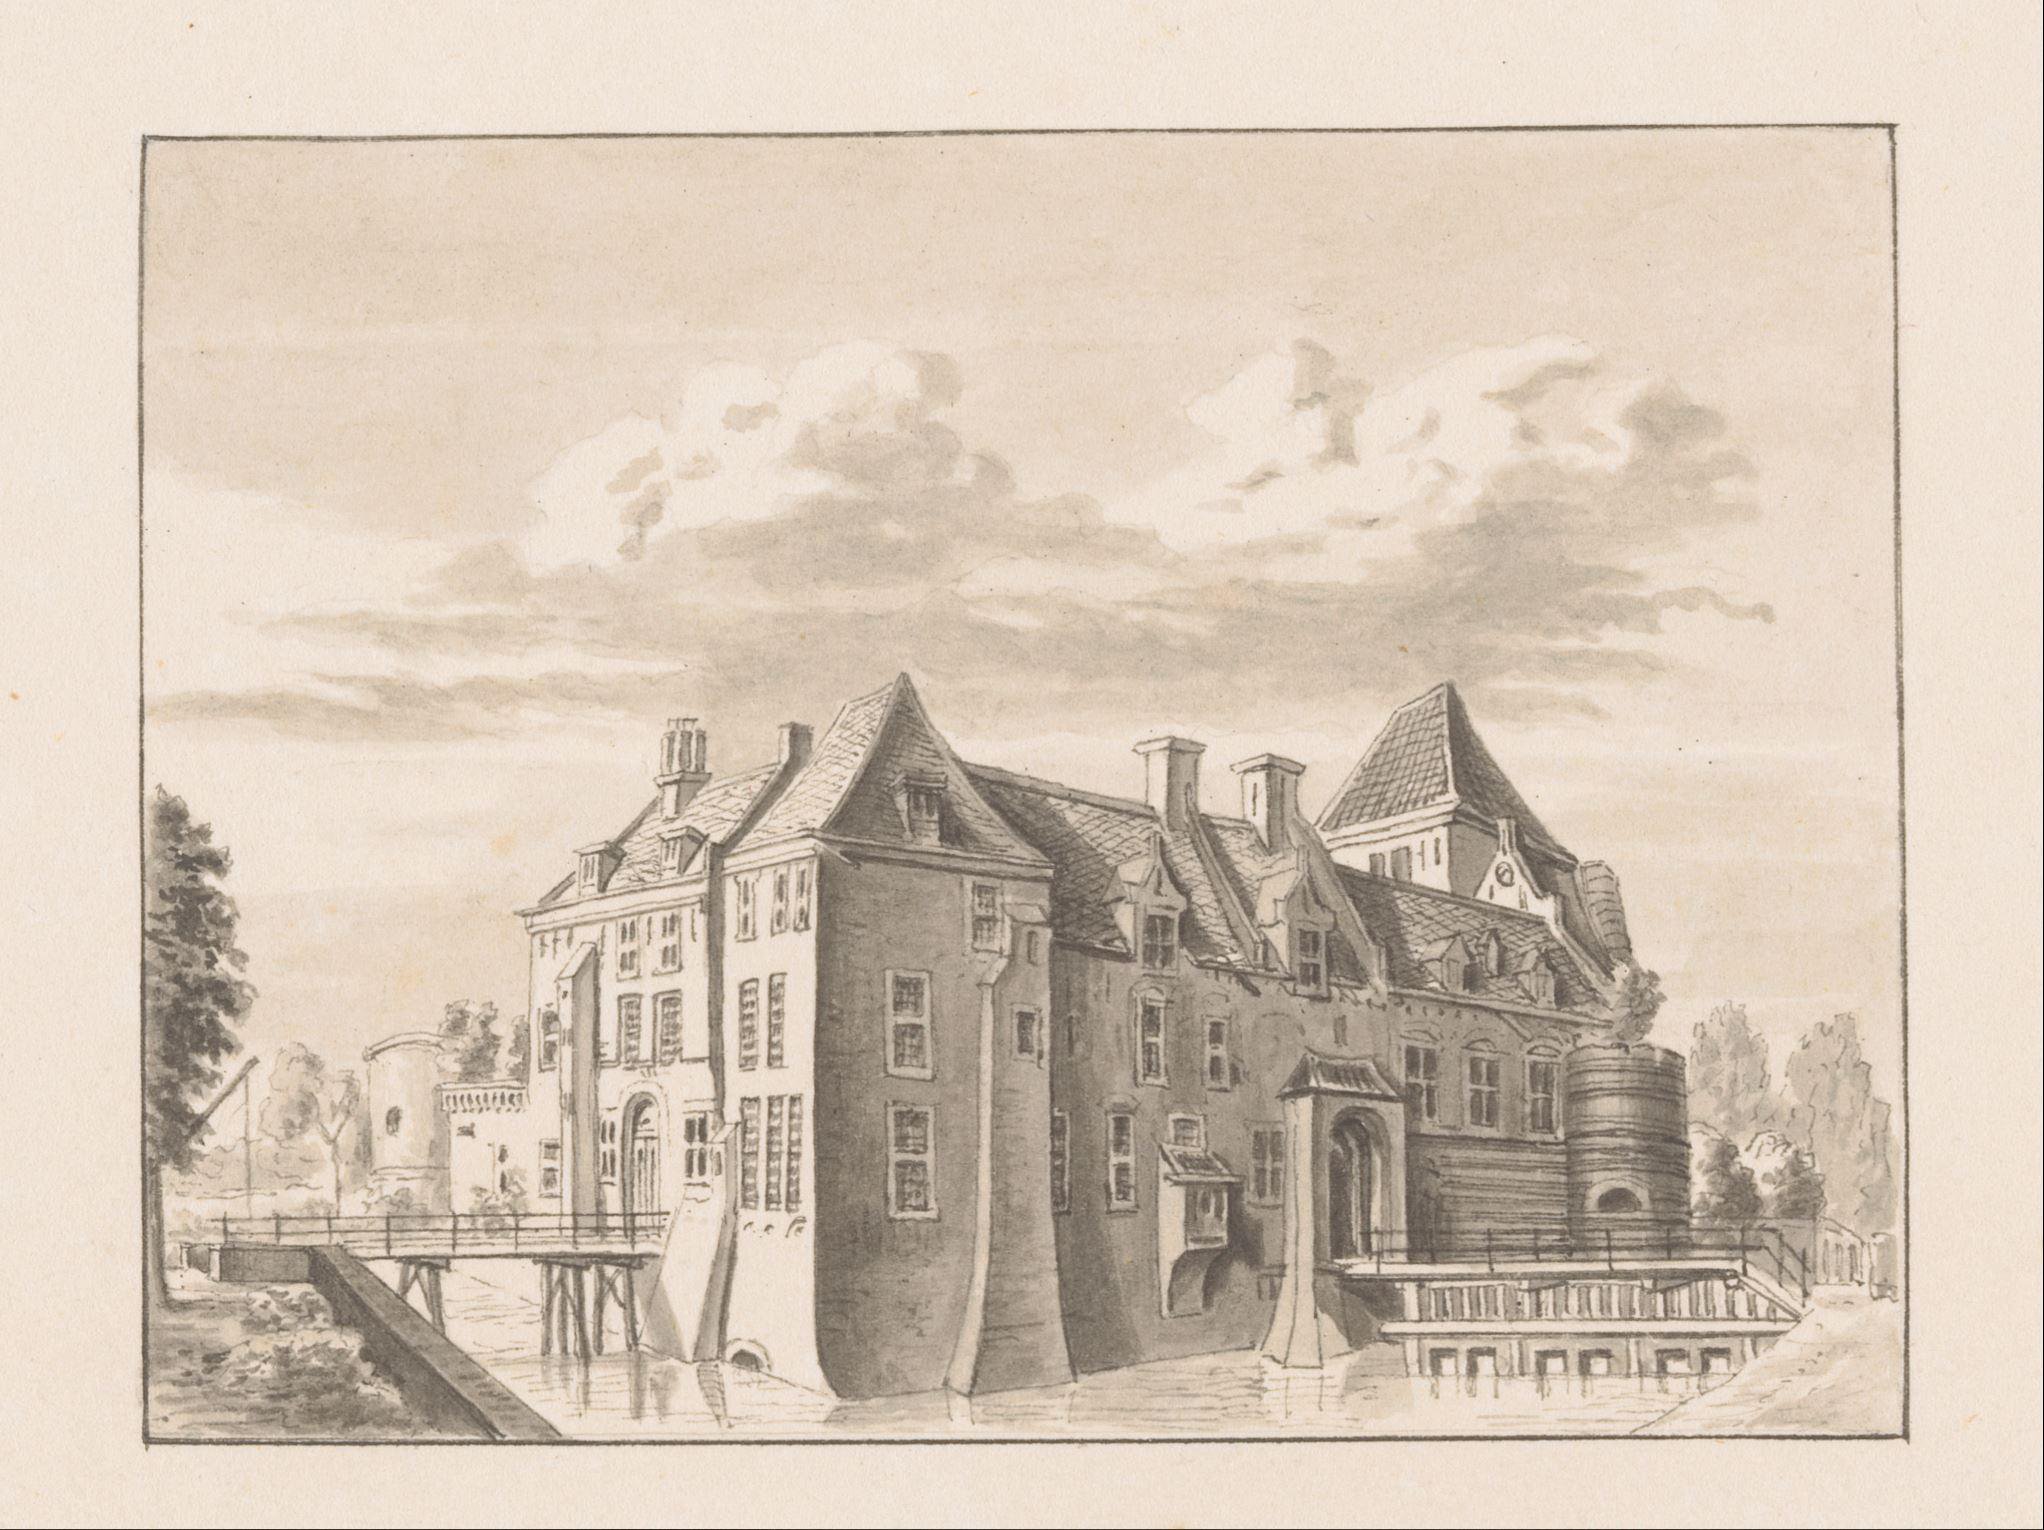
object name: kopie naar prent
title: Gezicht op kasteel IJsselstein in IJsselstein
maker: Anonymous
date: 1750-1850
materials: ink, paper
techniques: brush, drawing, pen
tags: castle, landscape with tower or castle